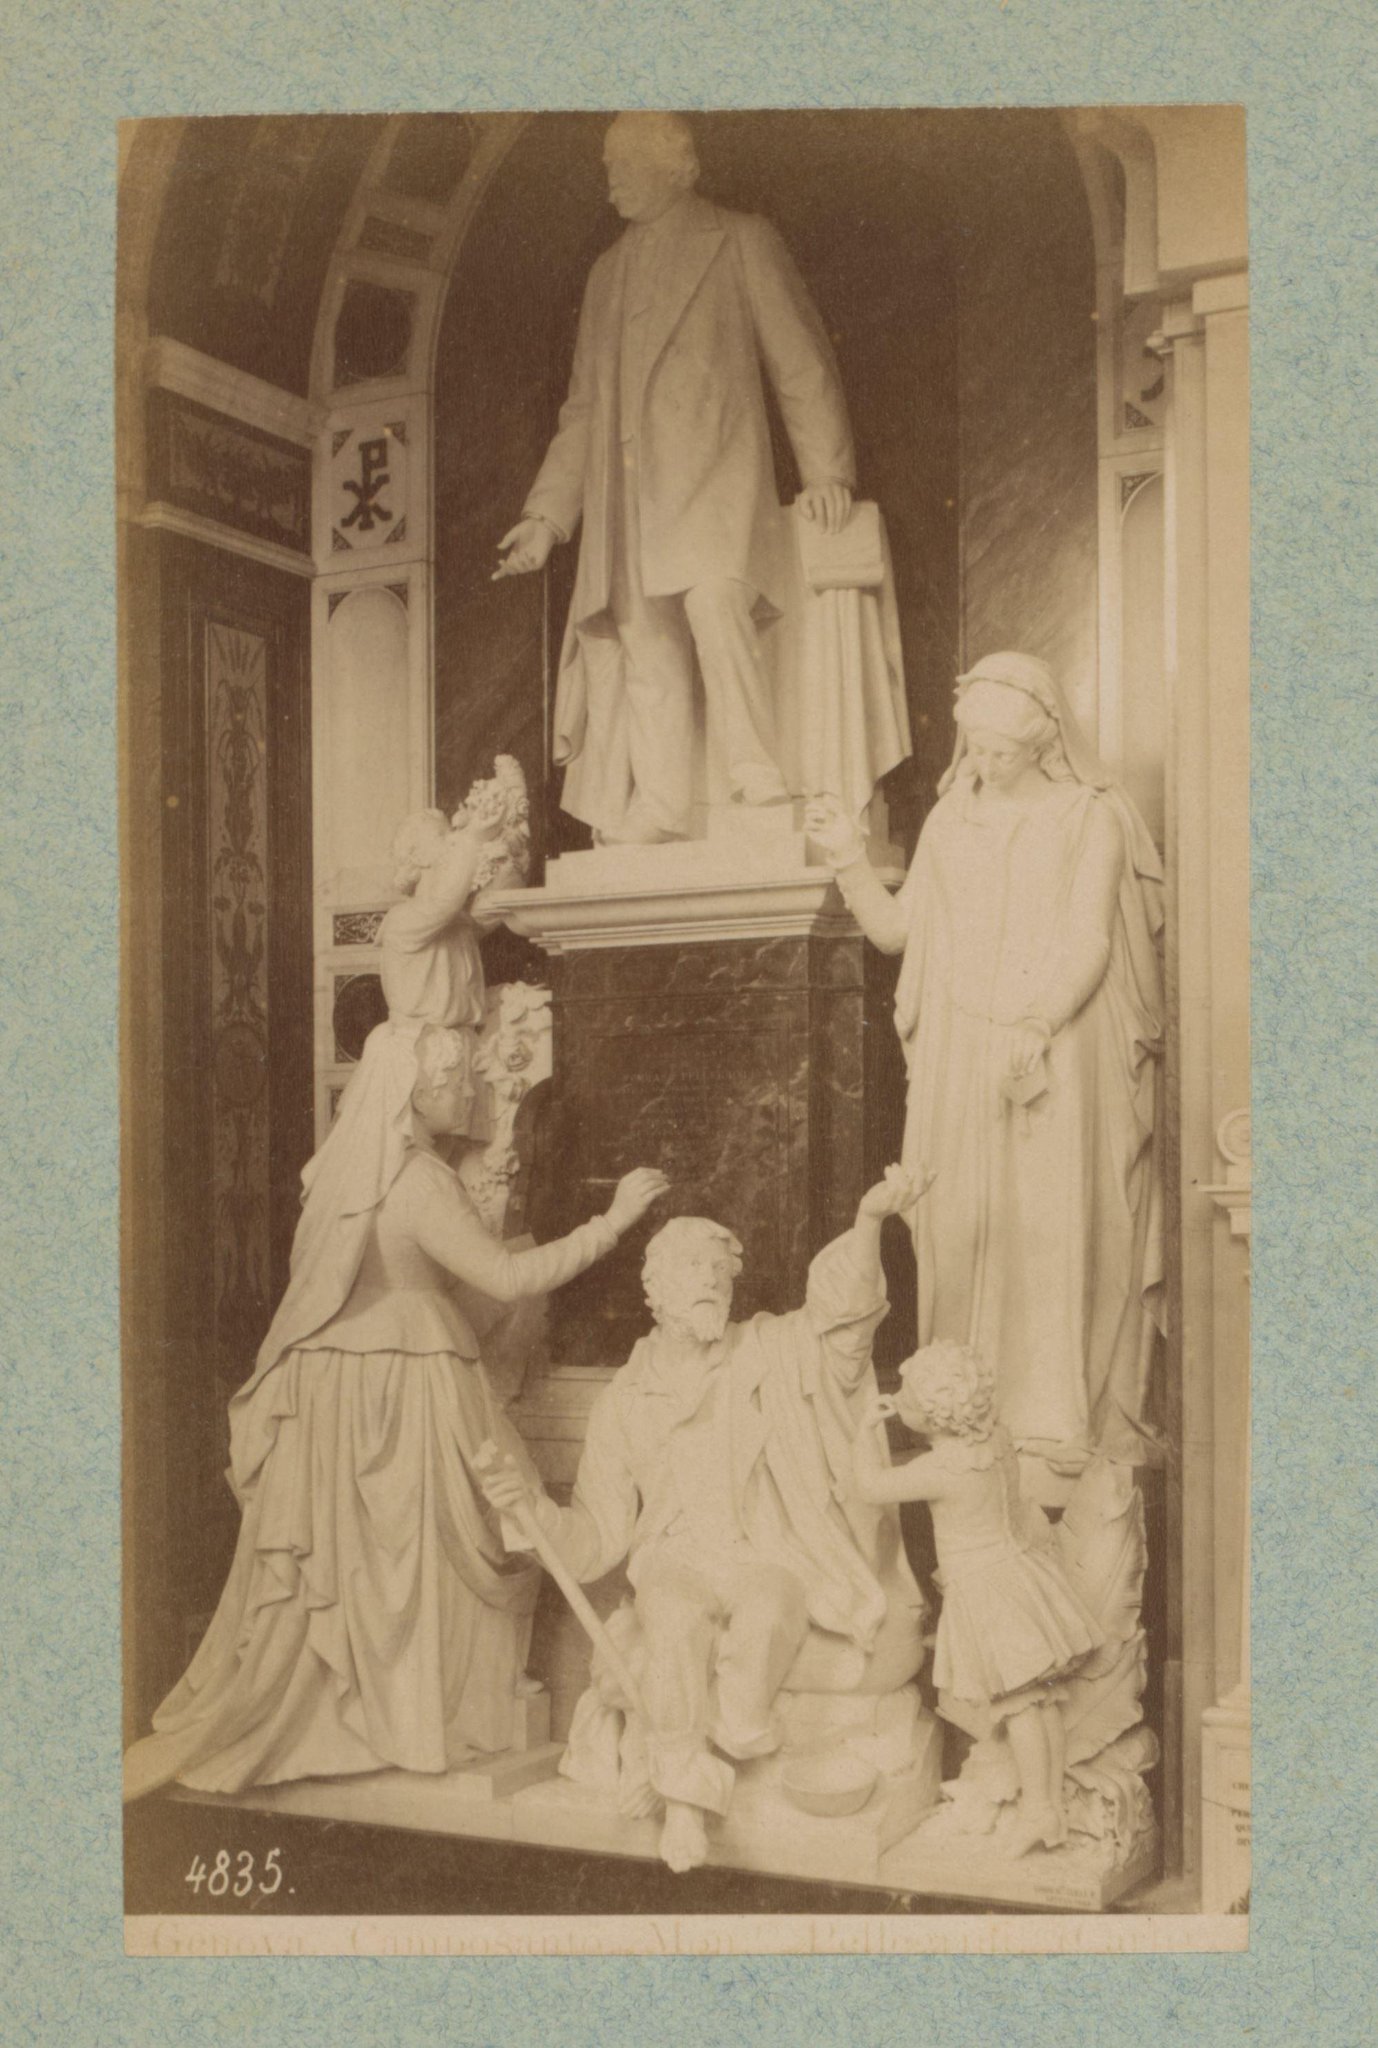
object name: photograph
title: Camposanto. Mon. Pellegrini (Carli)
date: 1888-1890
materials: cardboard, paper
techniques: albumen print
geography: genoa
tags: sculpture, grave-building, monumental tomb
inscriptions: collector's mark: ‘VOSMAER’, number: ‘4835.’